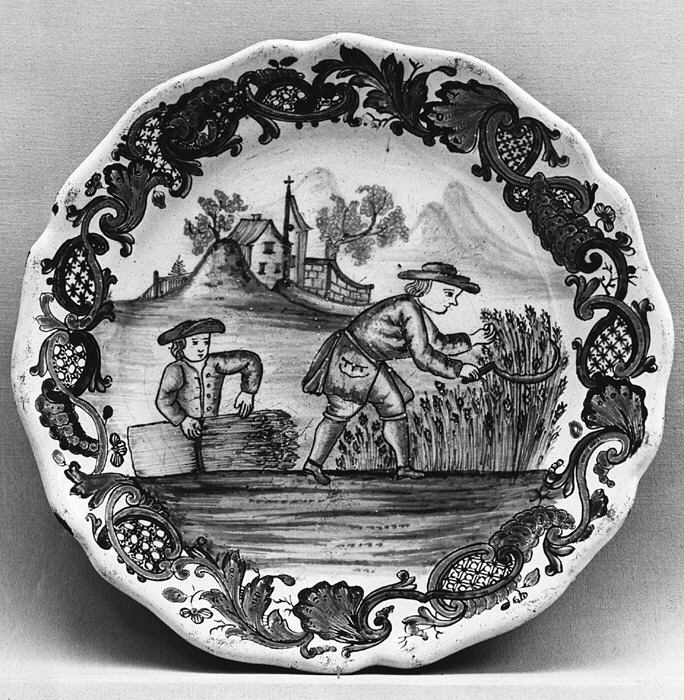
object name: plate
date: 1755-1765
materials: faience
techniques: glazing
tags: houses,men,working